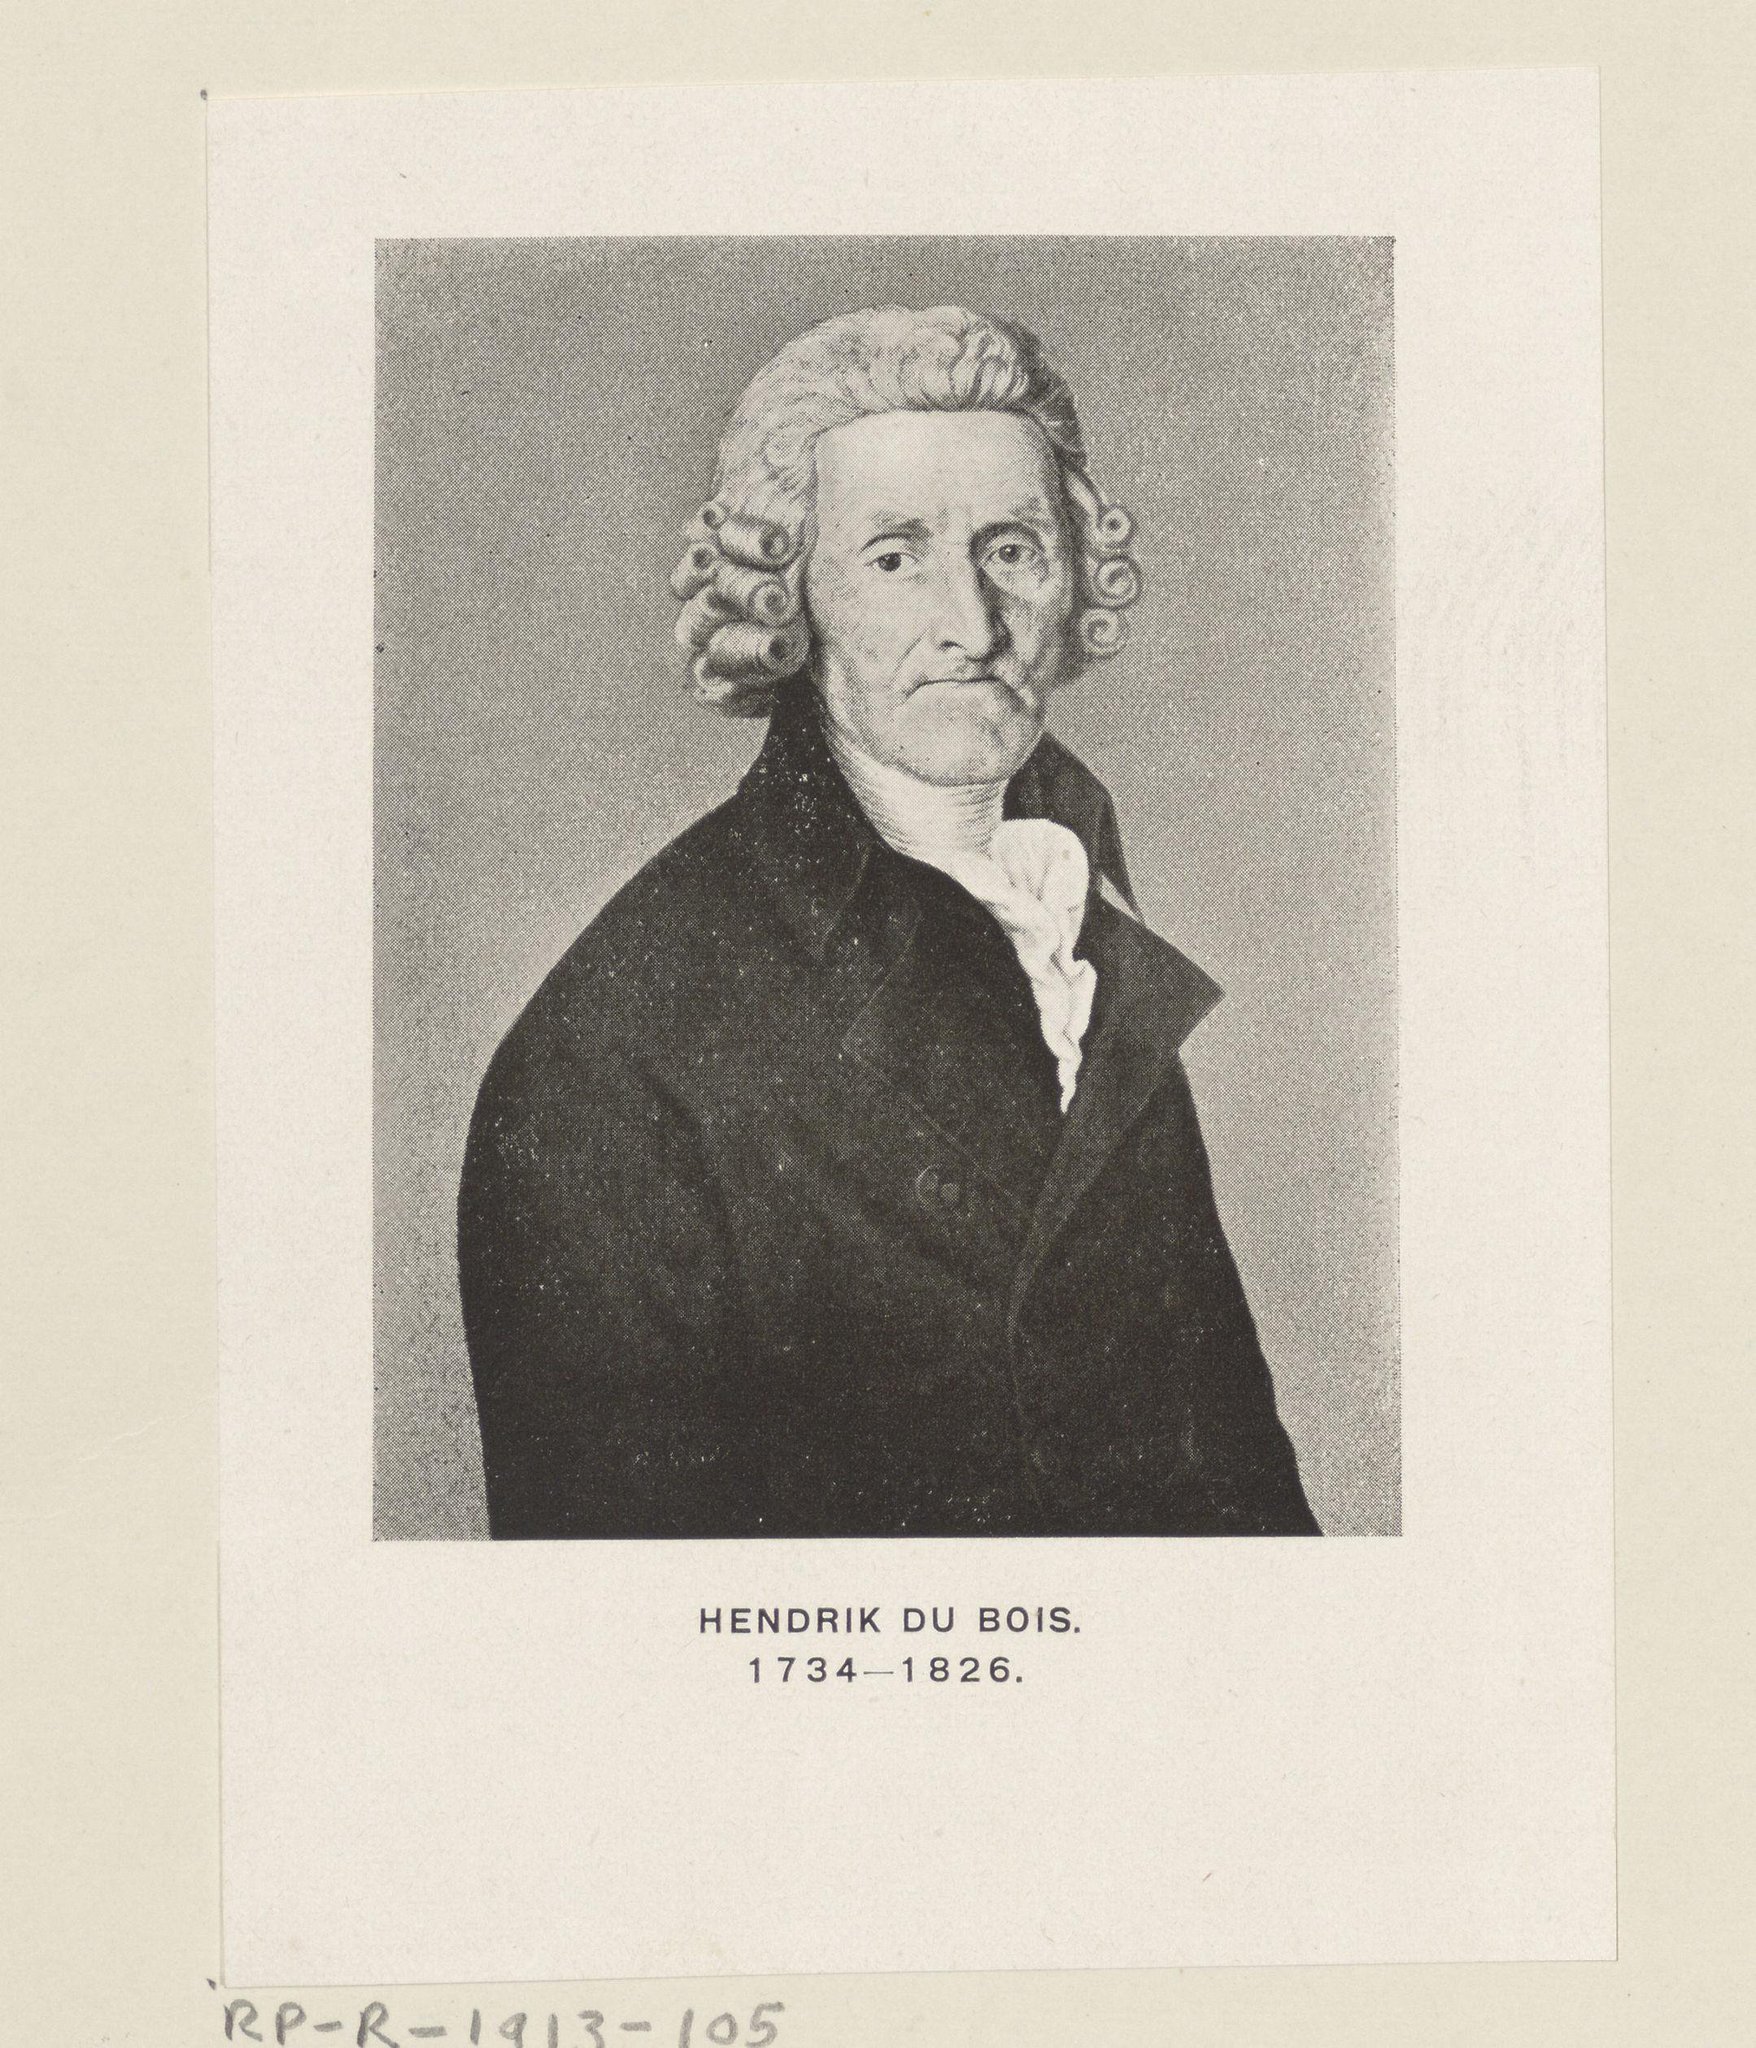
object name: photomechanical print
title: Portret van Hendrik du Bois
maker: Anonymous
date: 1913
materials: paper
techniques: autotype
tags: amsterdam, historical persons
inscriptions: collector's mark: Lugt 2228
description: Fotomechanische afdruk mogelijk uit: Nederland's Patriciaat. Den Haag: Centraal Bureau voor Genealogie, 1913.